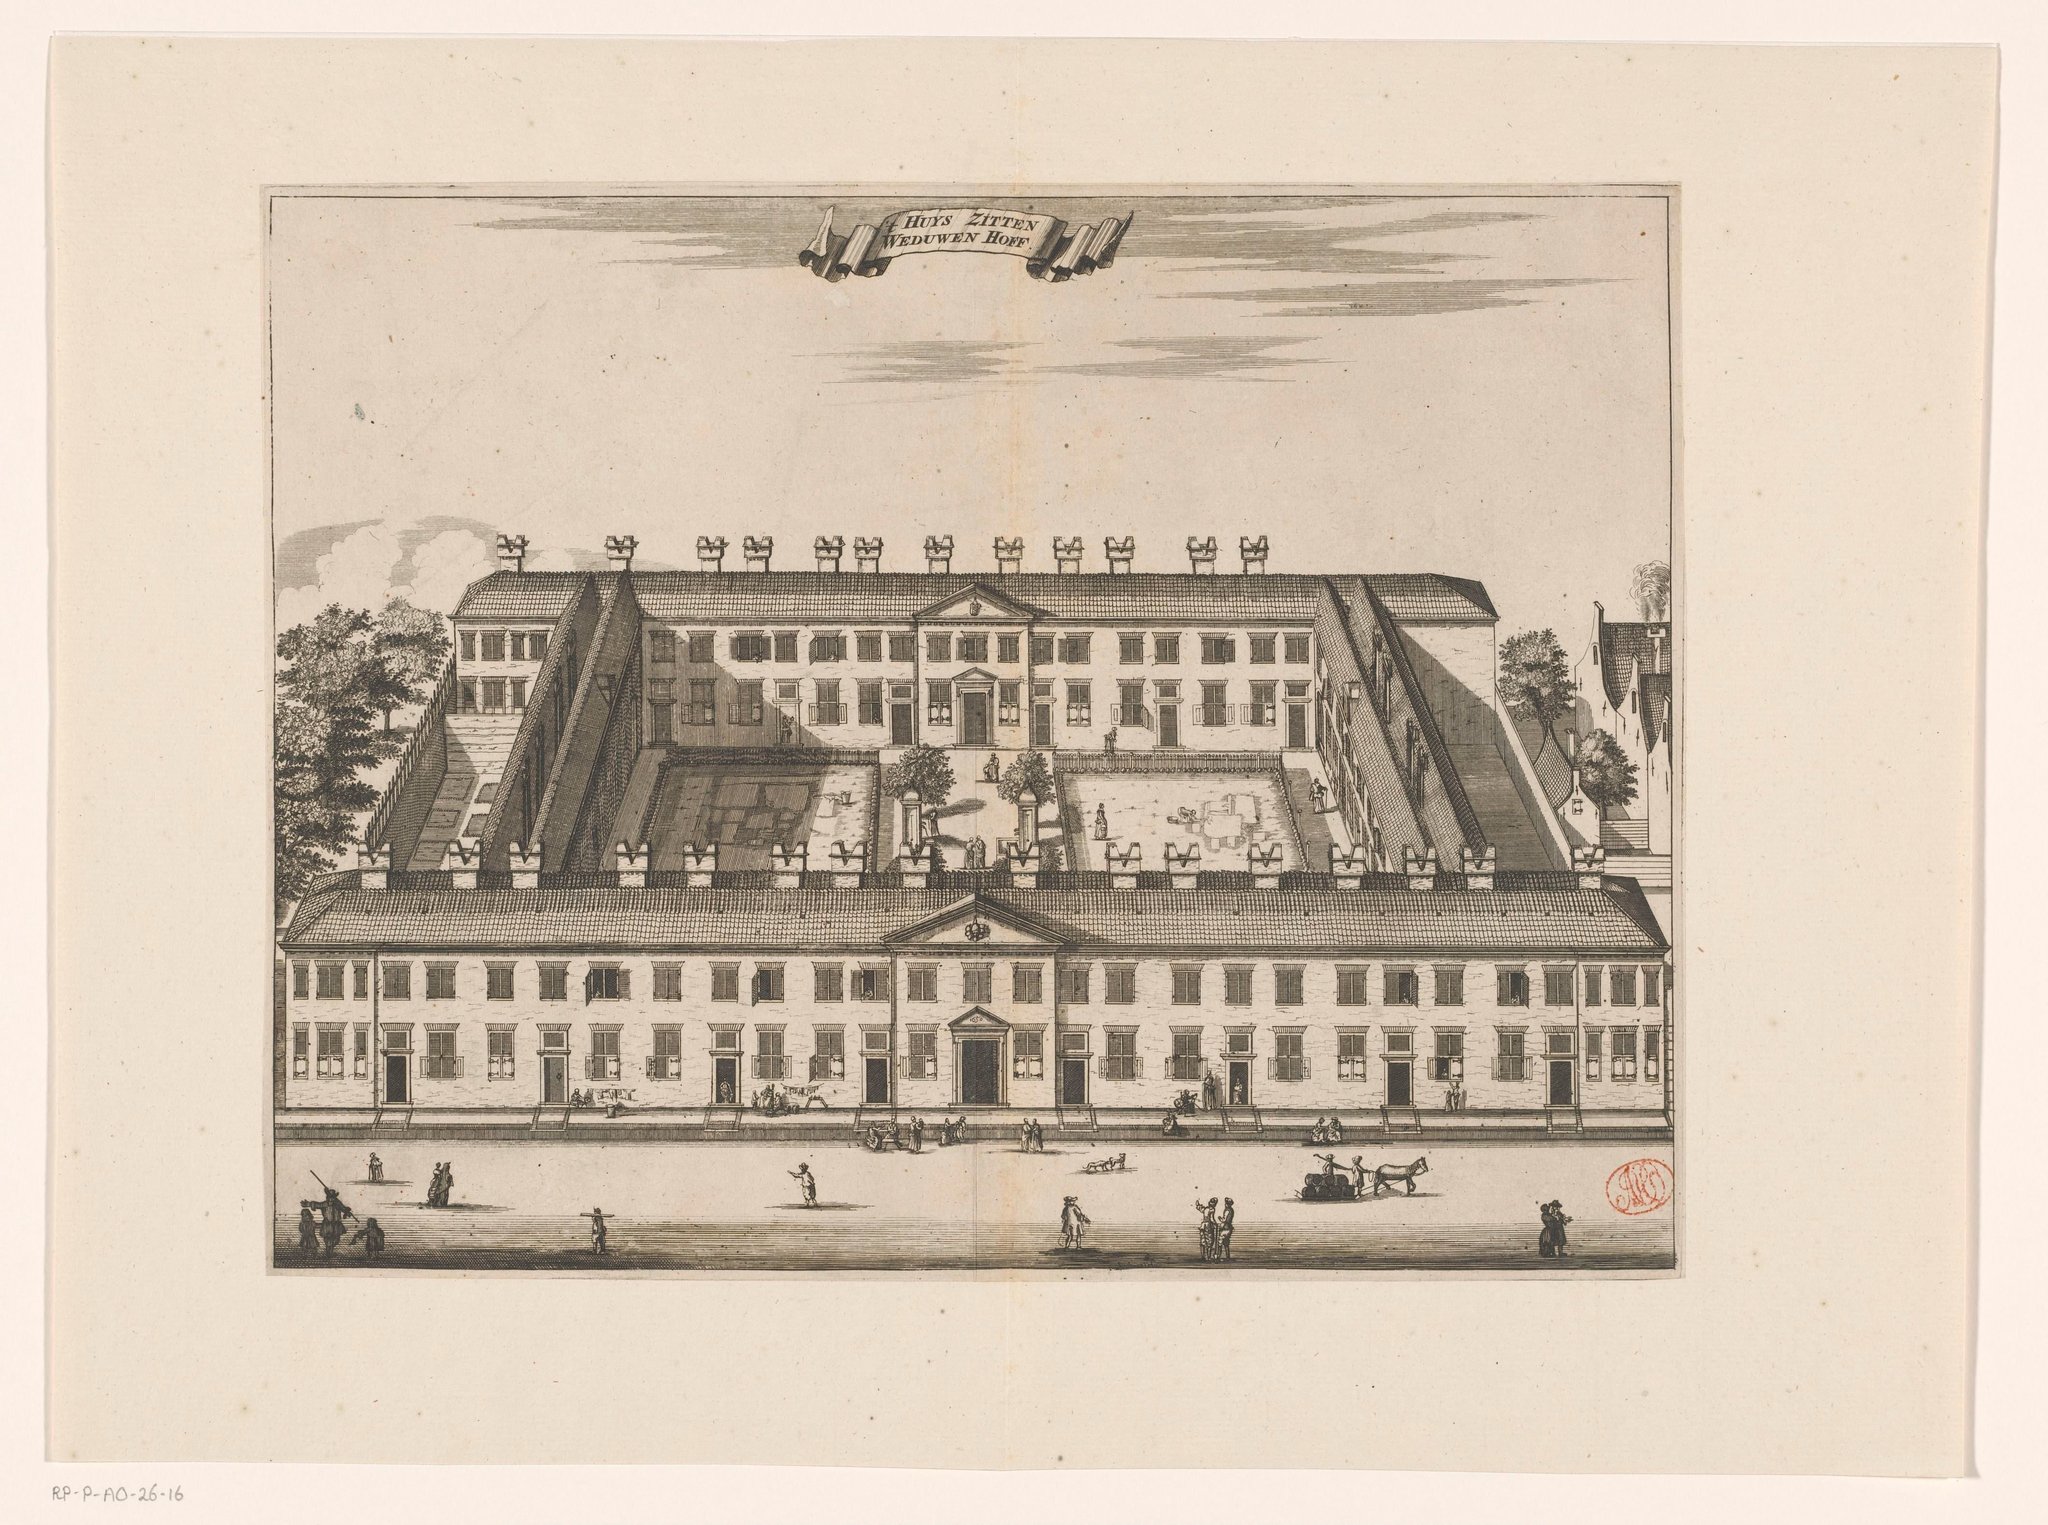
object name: print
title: Gezicht in vogelvlucht op het Huiszittenweduwenhof (Kartuizerhof) te Amsterdam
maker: Anonymous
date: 1693-1694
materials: paper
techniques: engraving, etching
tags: public welfare, poorhouse, courtyard, old-people's home, street (+ city(-scape) with figures, staffage)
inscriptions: collector's mark: Lugt 195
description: Huidige staat van prent ook gebruikt in: Commelin, Caspar. Beschryvinge van Amsterdam, desselfs eerste oorspronk uyt den Huyse (…). 2 delen. Amsterdam: Abraham Wolfgang, Gillis Janssonius van Waesberge, Johannes Janssonius van Waesberge II, weduwe Dirk Boom I, Hendrick Boom en Rembertus Goethals, 1693. En in: Commelin, Caspar. Beschryvinge van Amsterdam, zynde een naukeurige verhandelinge van desselfs eerste oorspronk uyt (…). 2 delen. Amsterdam: weduwe Aart Dircksz Oossaan, 1694. Latere staat ook gebruikt in: Commelin, Caspar. Beschryvinge van Amsterdam, zynde een naukeurige verhandelinge van desselfs eerste oorspronk uyt (…). 2 delen. 2e druk. Amsterdam: Andries van Damme, Johannes Ratelband, weduwe A. van Aaltwyk en Hermanus Uytwerf, 1726.